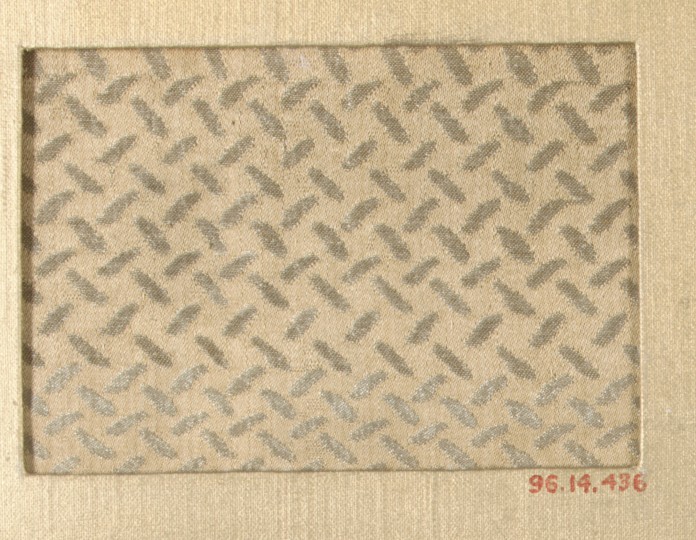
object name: piece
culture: japanese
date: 1701-1900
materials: silk